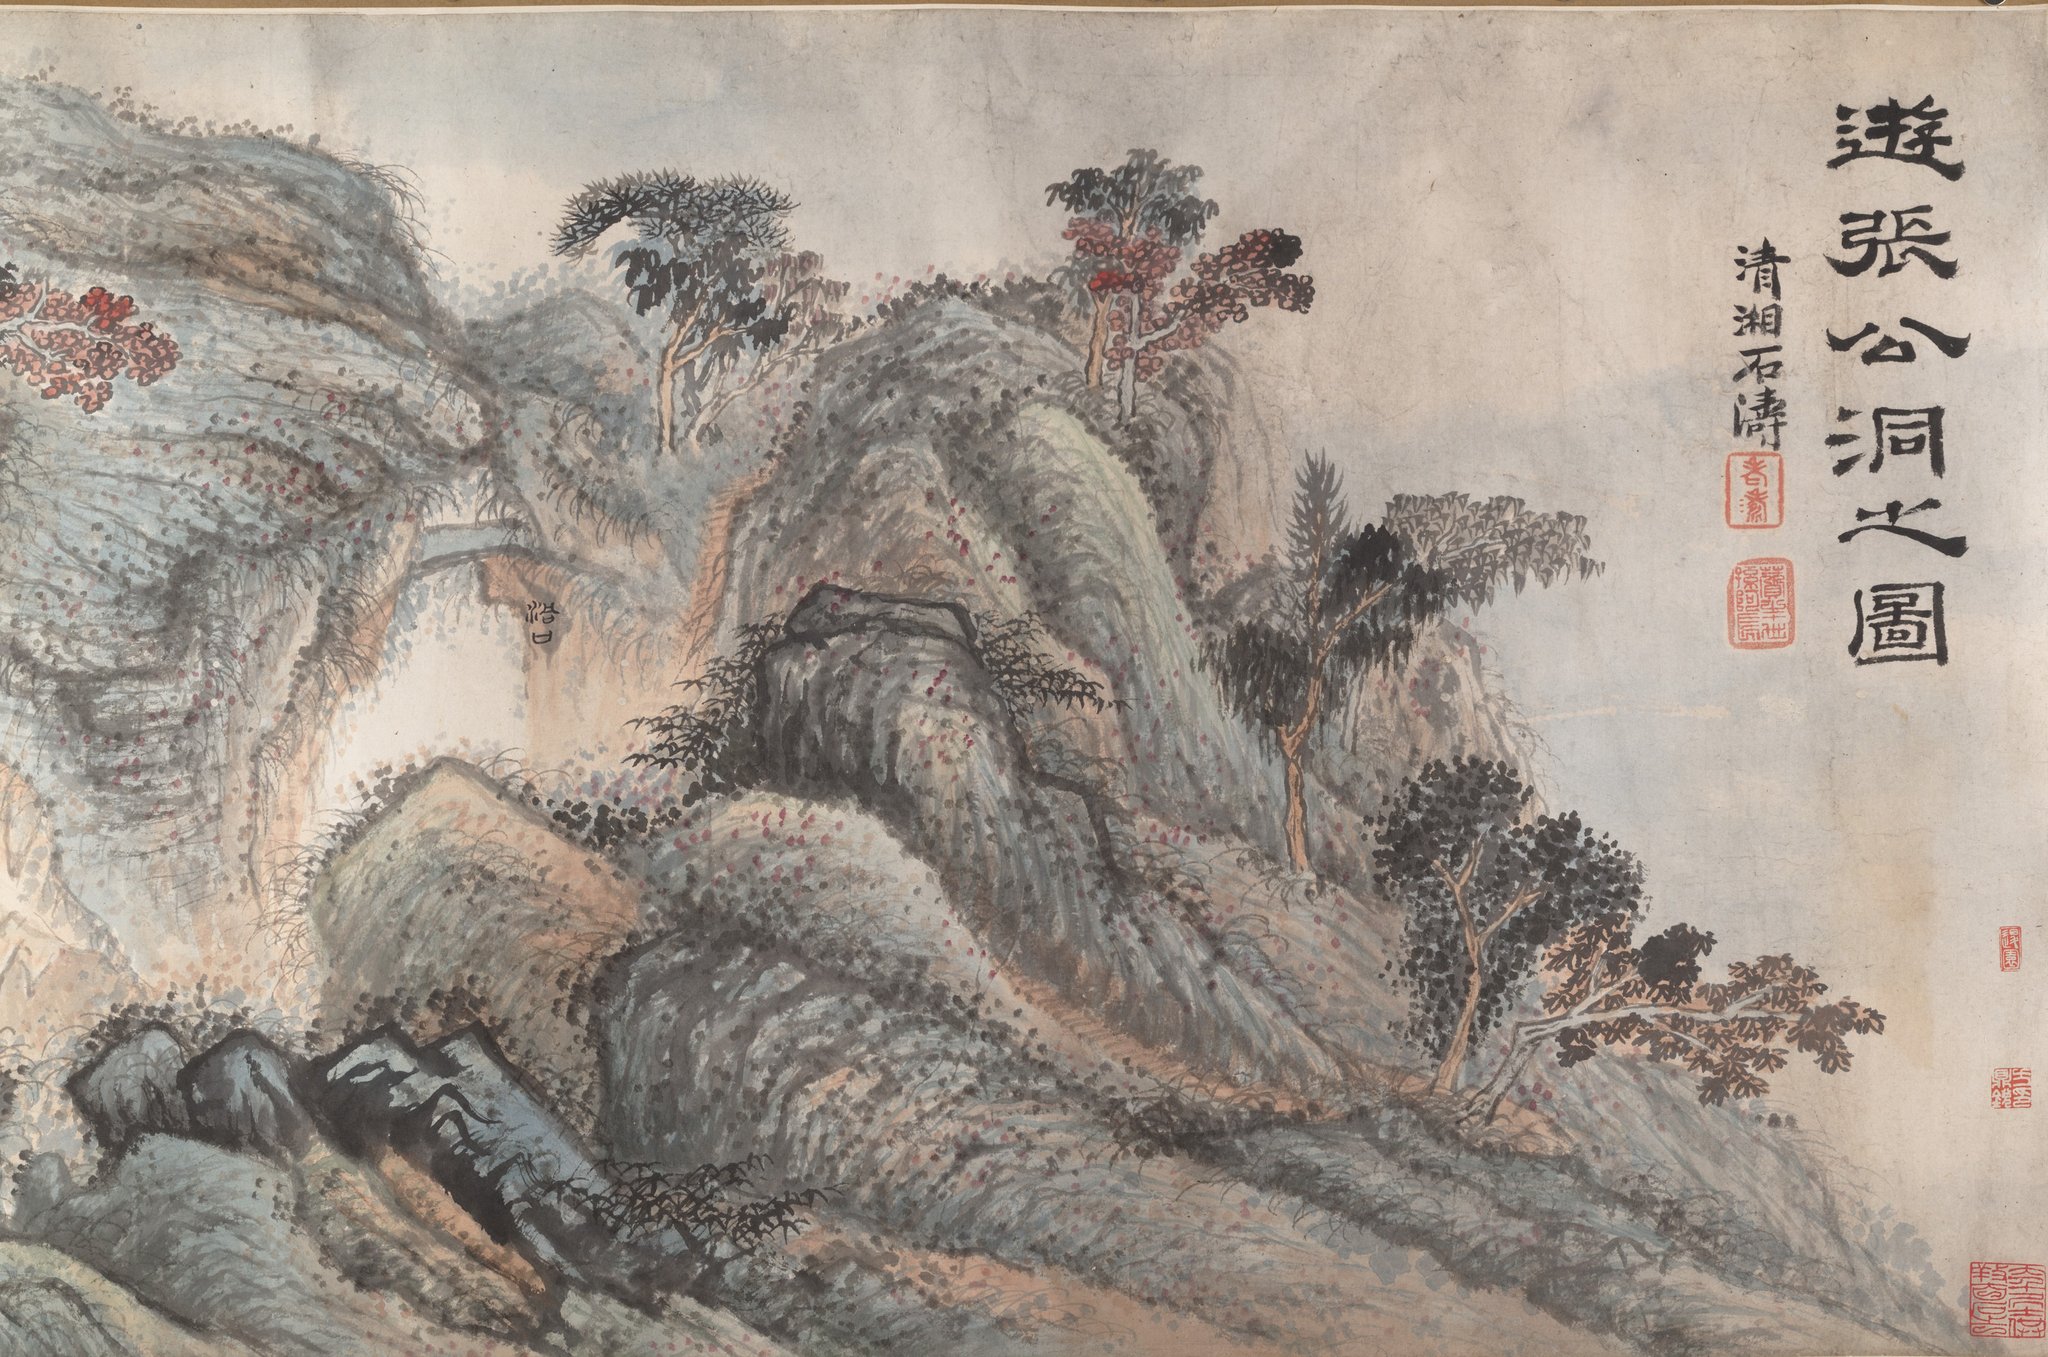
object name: handscroll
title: Outing to Zhang Gong's Grotto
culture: chinese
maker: shitao (zhu ruoji)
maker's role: artist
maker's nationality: chinese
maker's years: 1642-1707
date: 1700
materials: ink, paper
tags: landscapes,trees